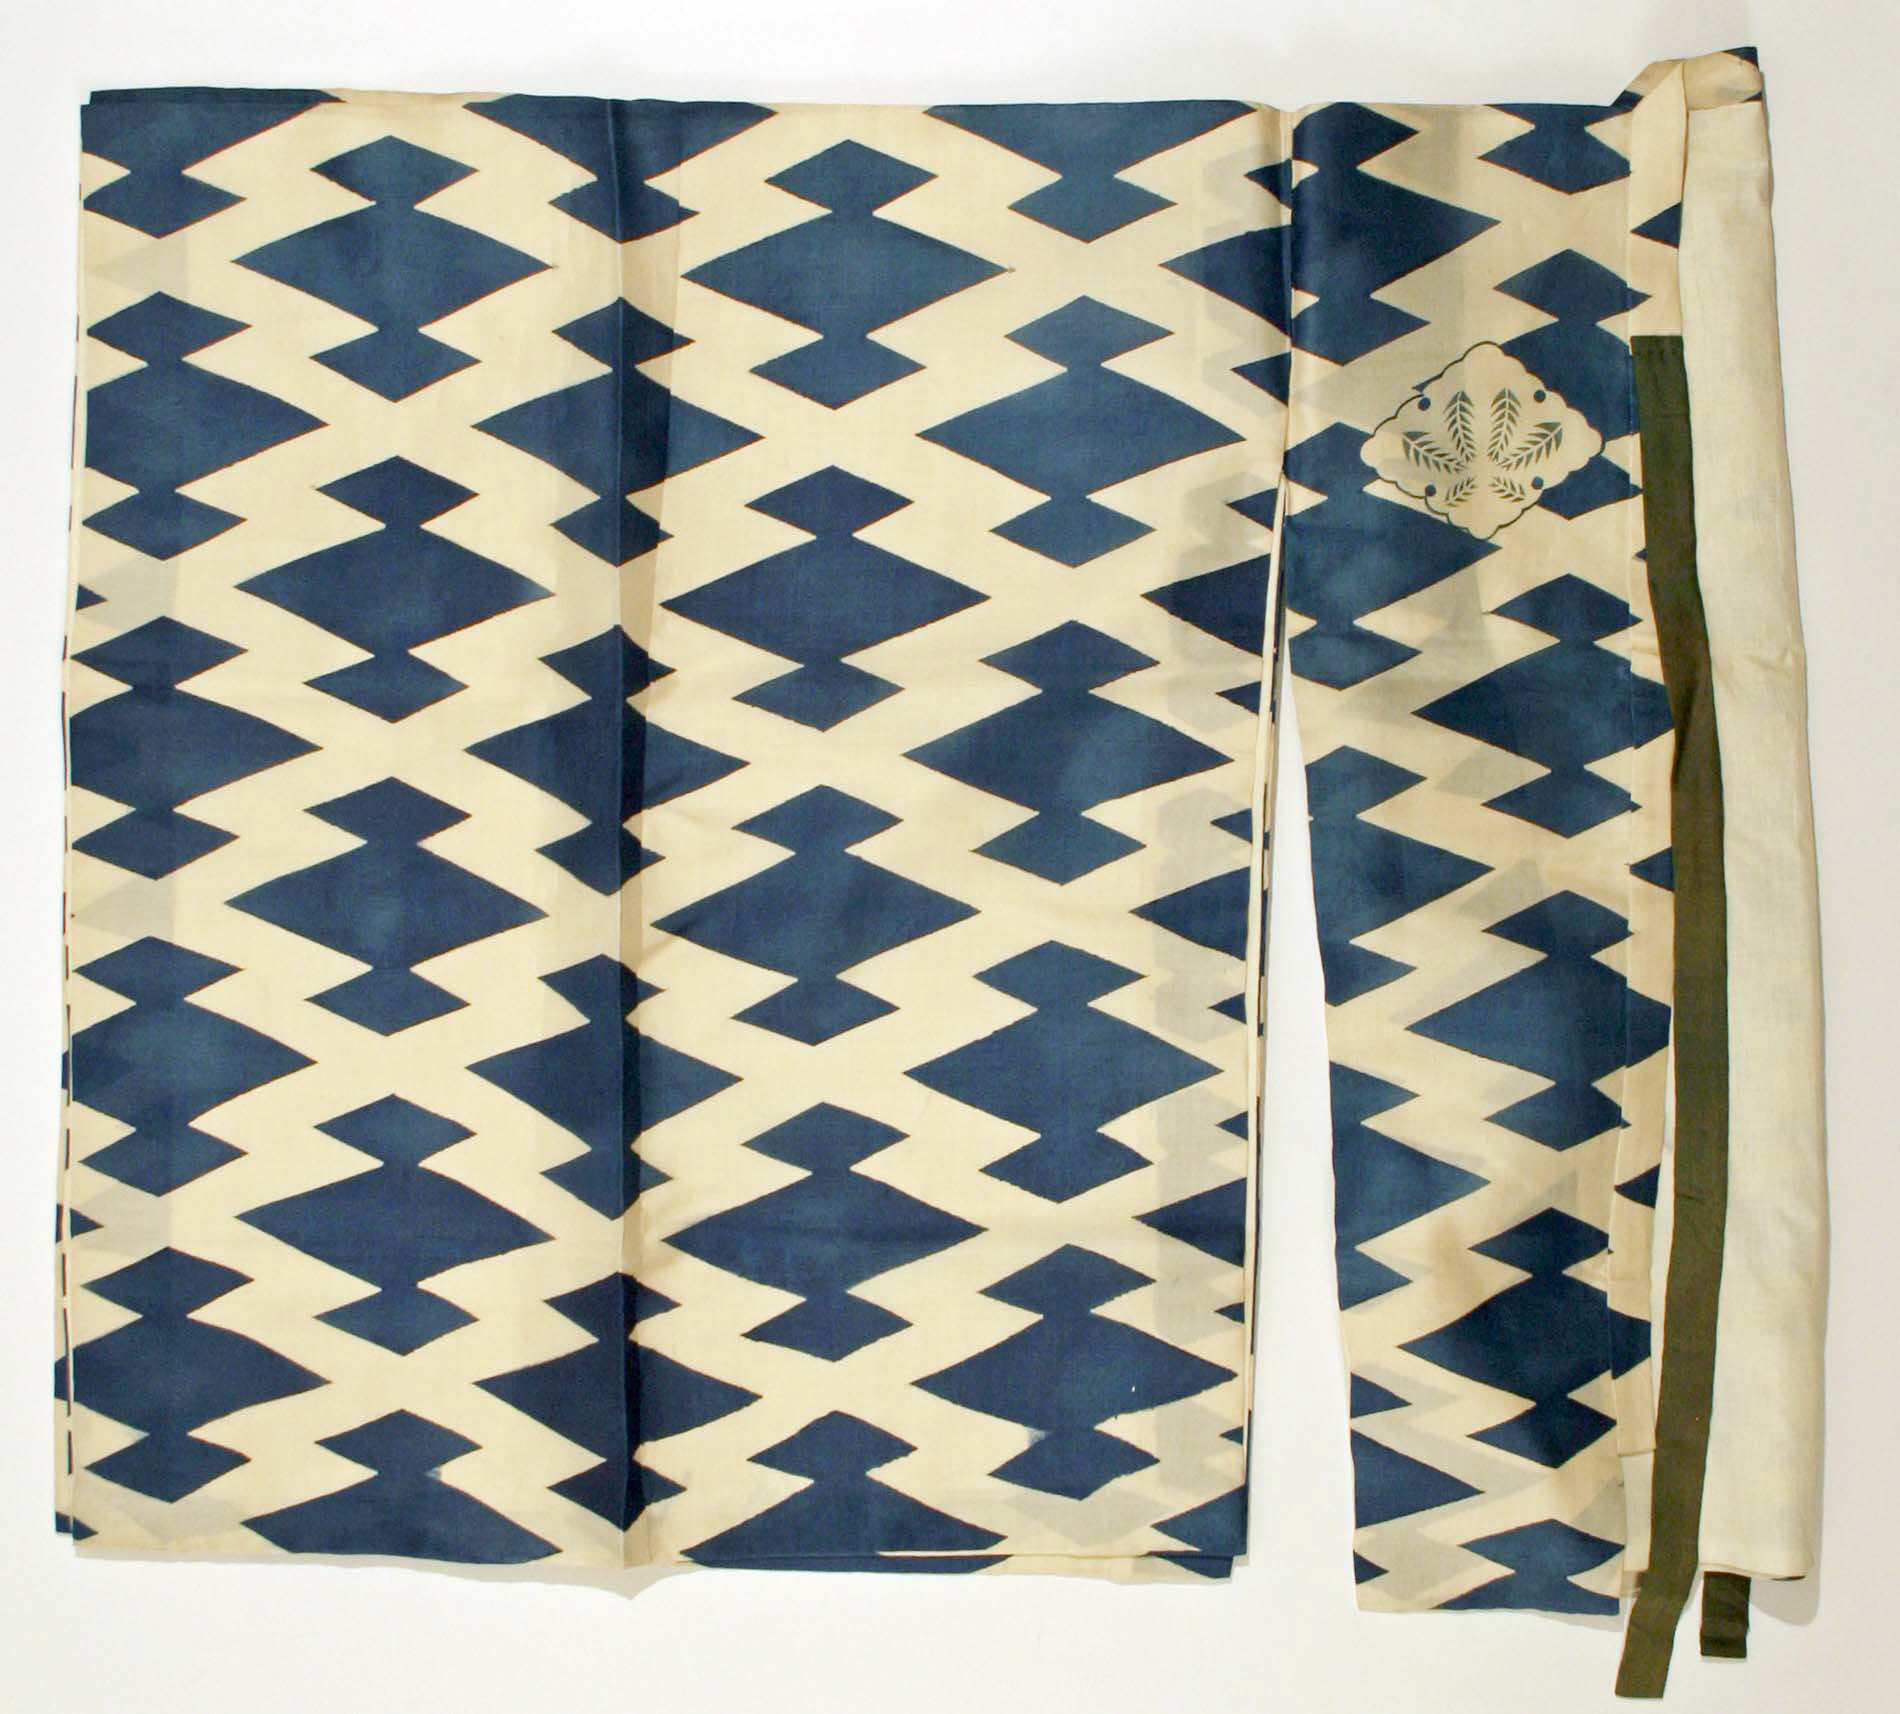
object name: theatrical costume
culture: japanese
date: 1868-1912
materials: silk